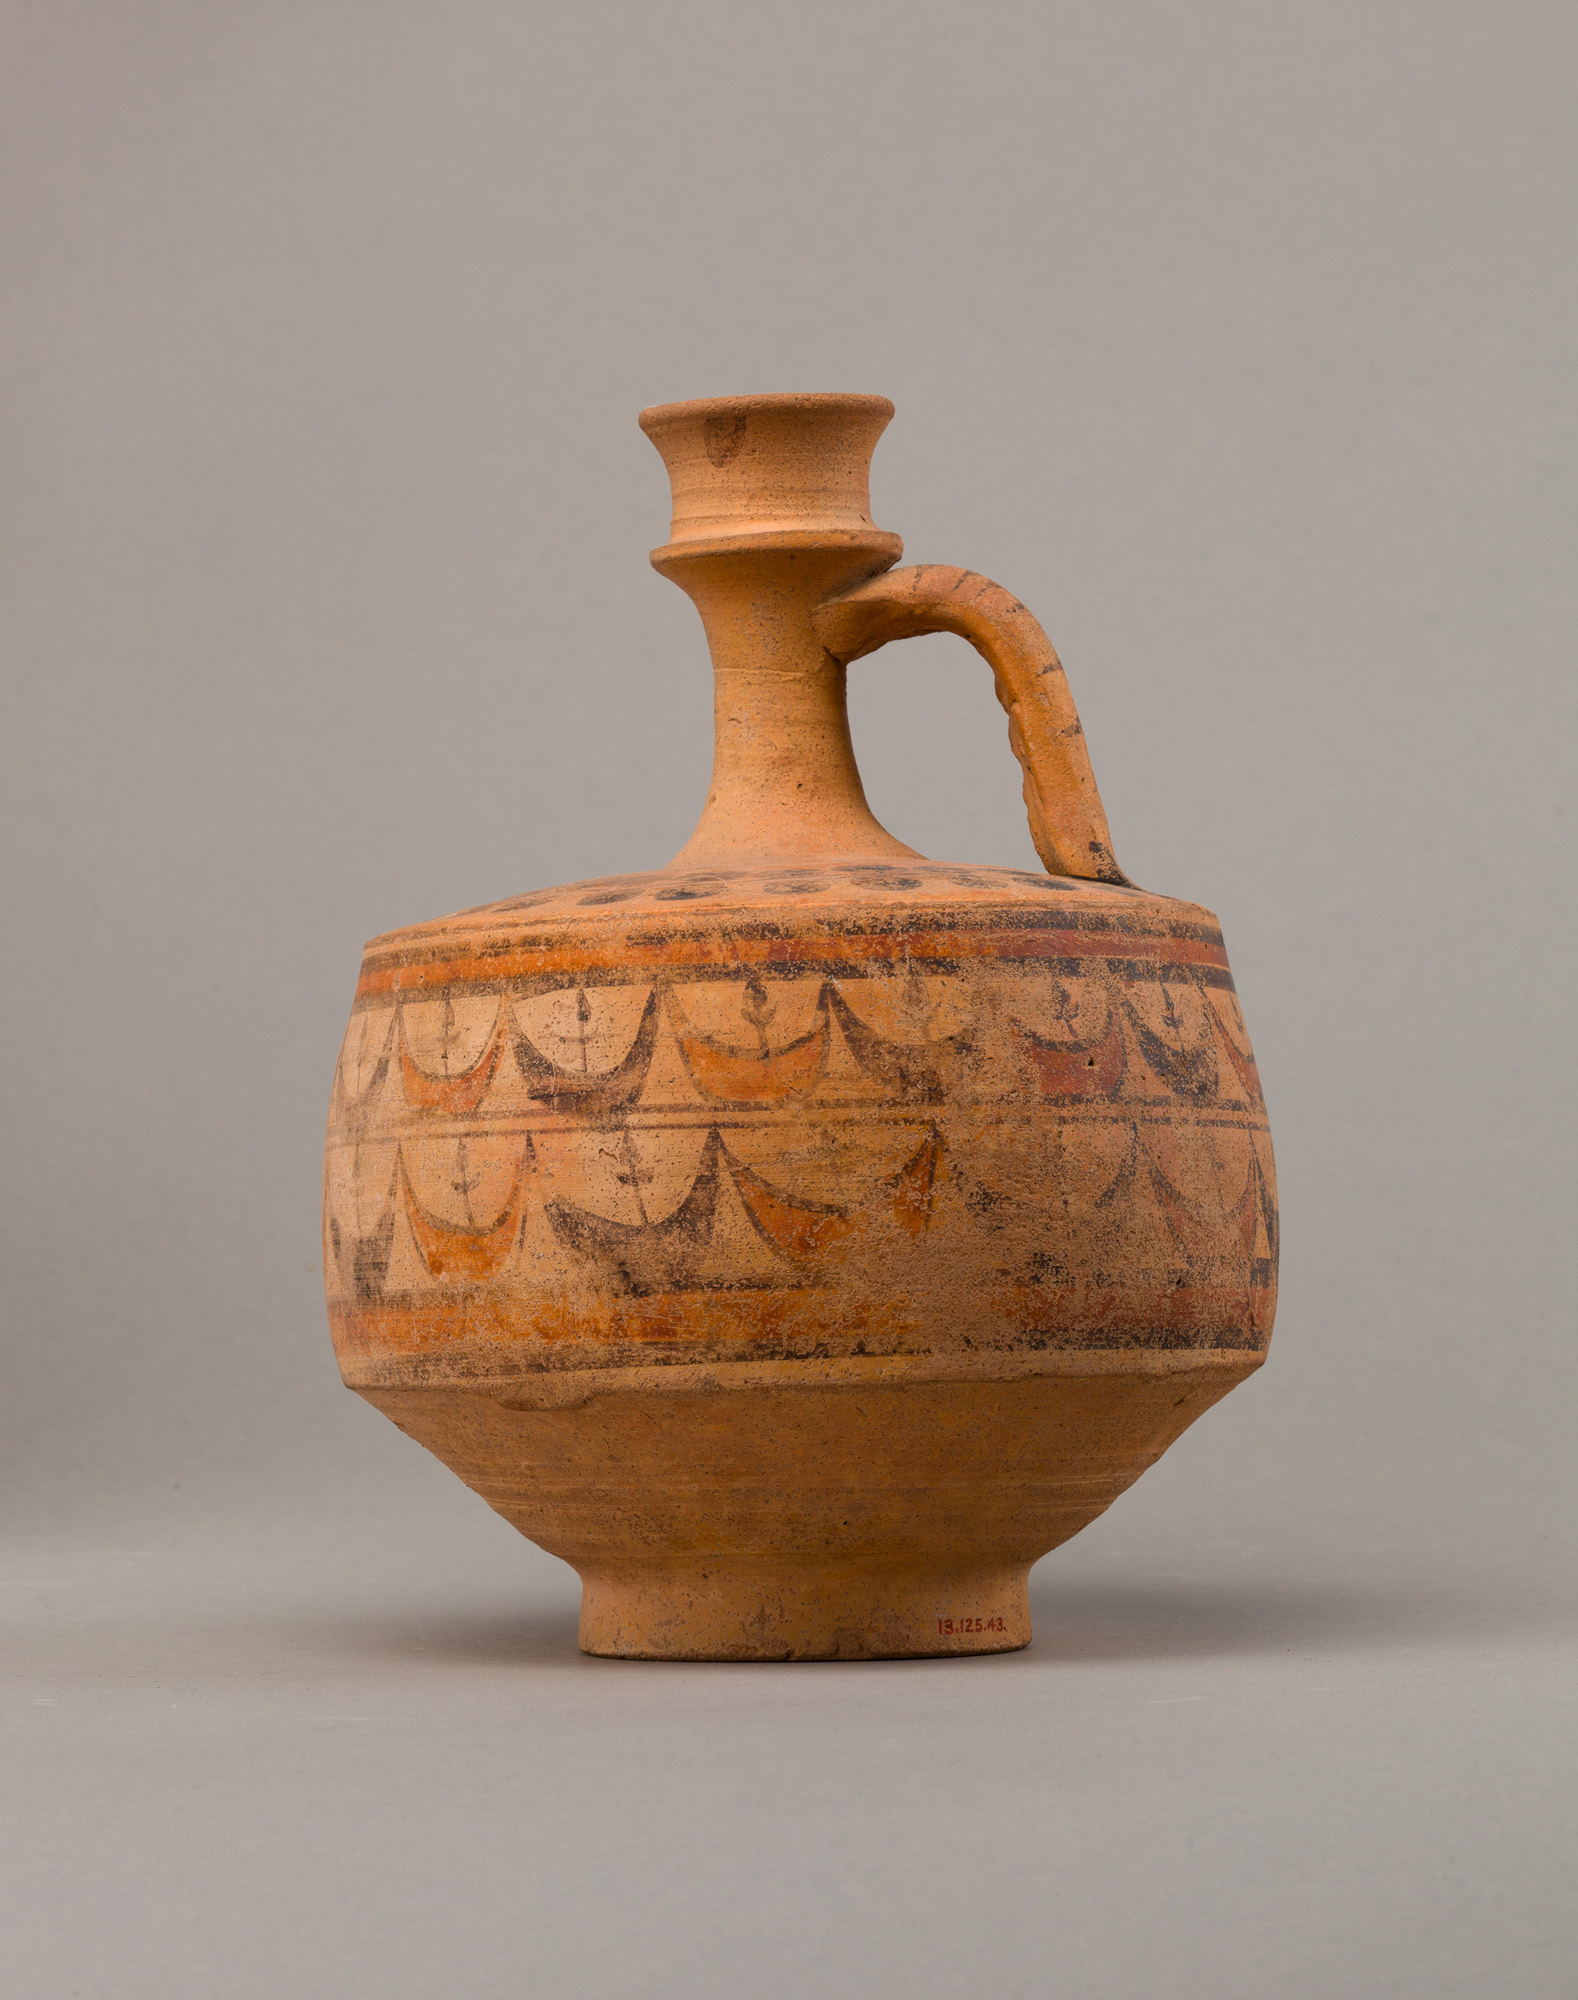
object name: jug, painted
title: Jug with painted decoration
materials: paint, pottery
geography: nubia